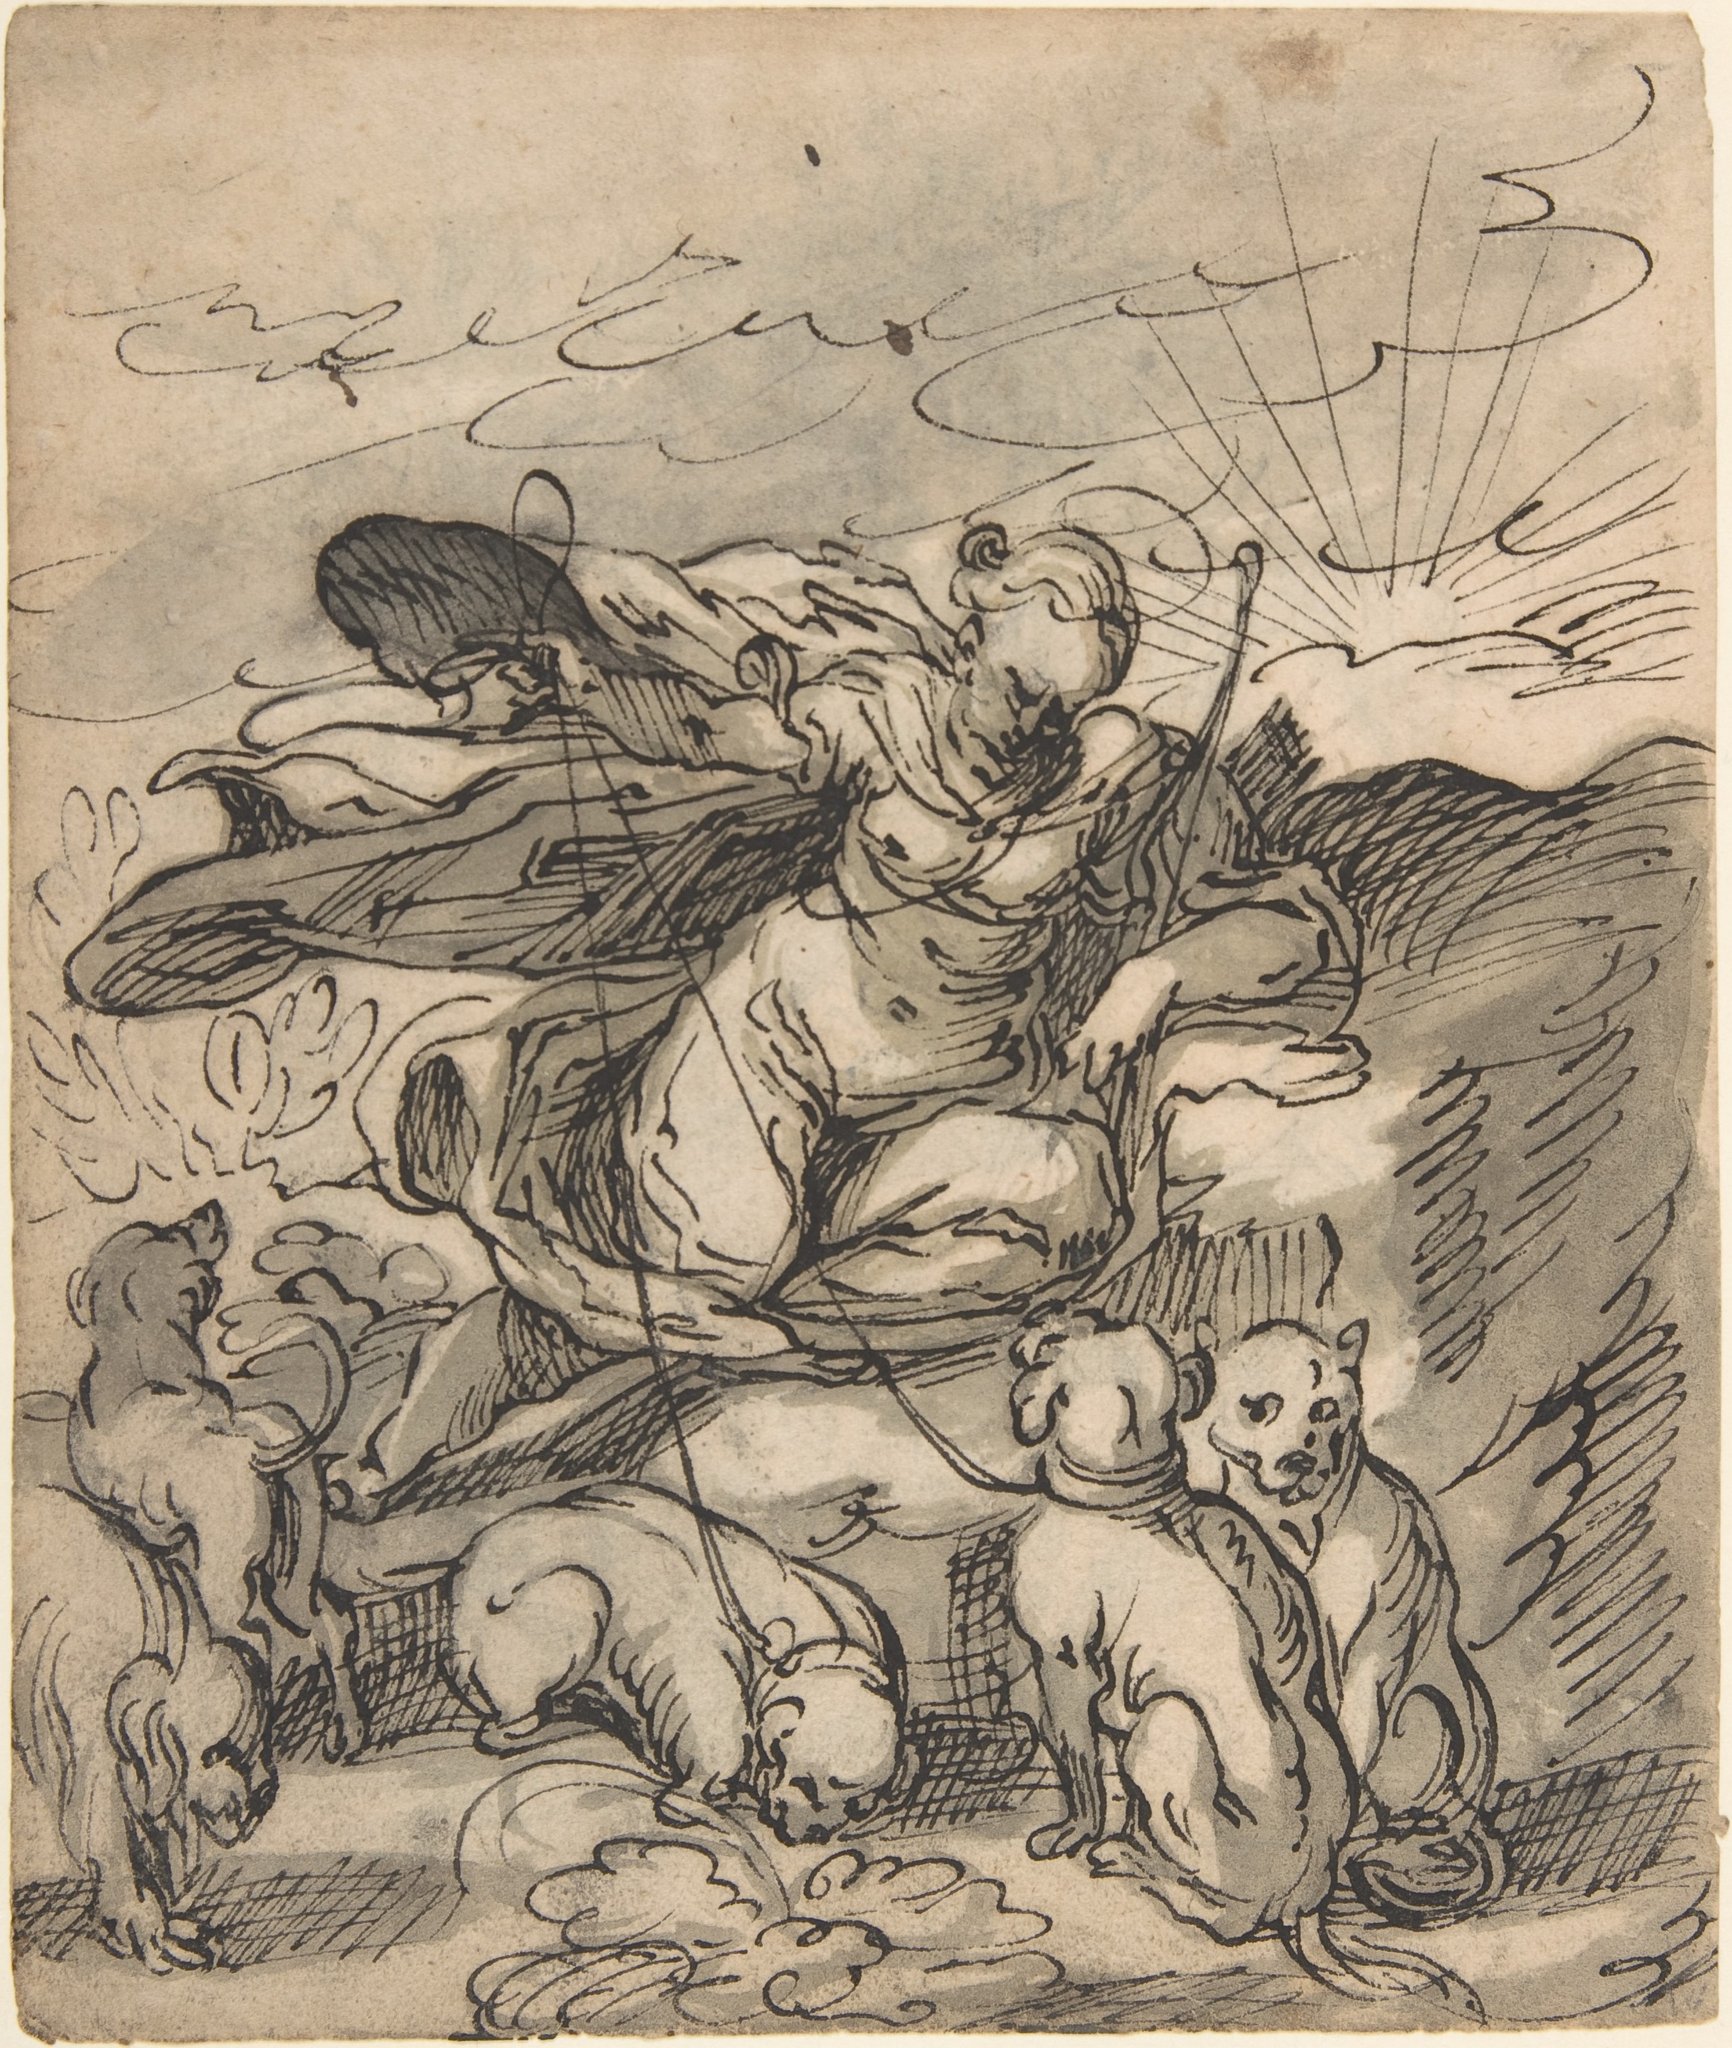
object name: drawing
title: Diana Resting with Her Hounds (recto); Flora Seated by a Vase with Two Harks on the Ground, after Jost Amman (verso)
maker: hermann weyer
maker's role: artist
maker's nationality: german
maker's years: 1596-1621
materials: ink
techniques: pen, wash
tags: diana,dogs,vases